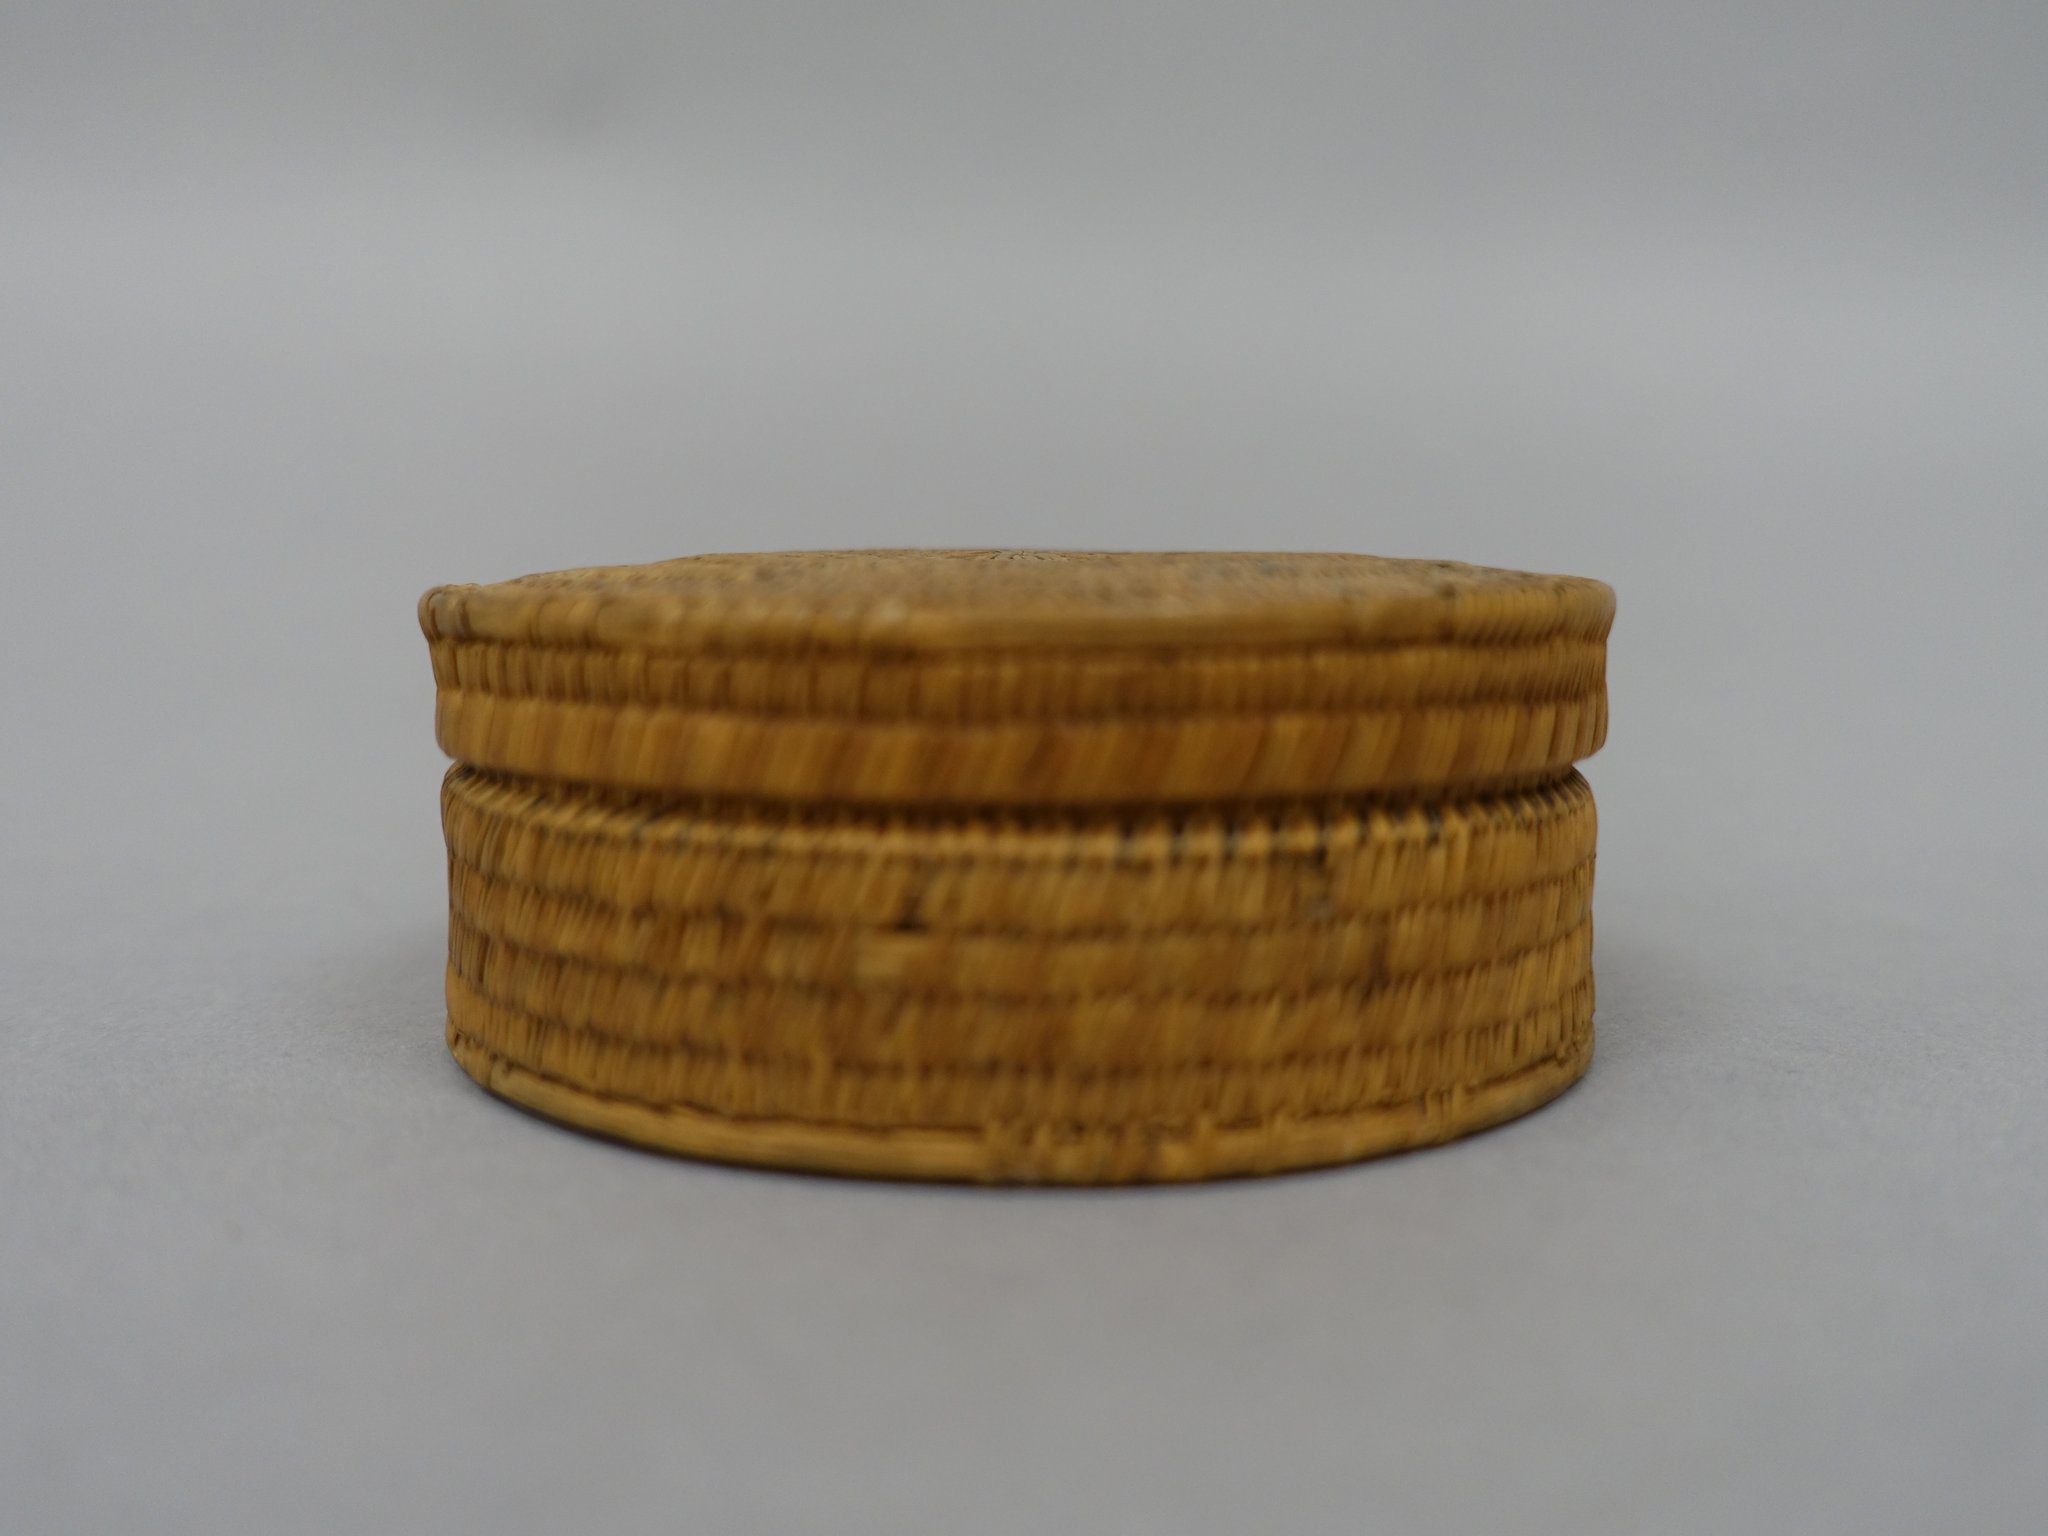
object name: box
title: Covered Box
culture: japanese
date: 1801-1900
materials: bamboo